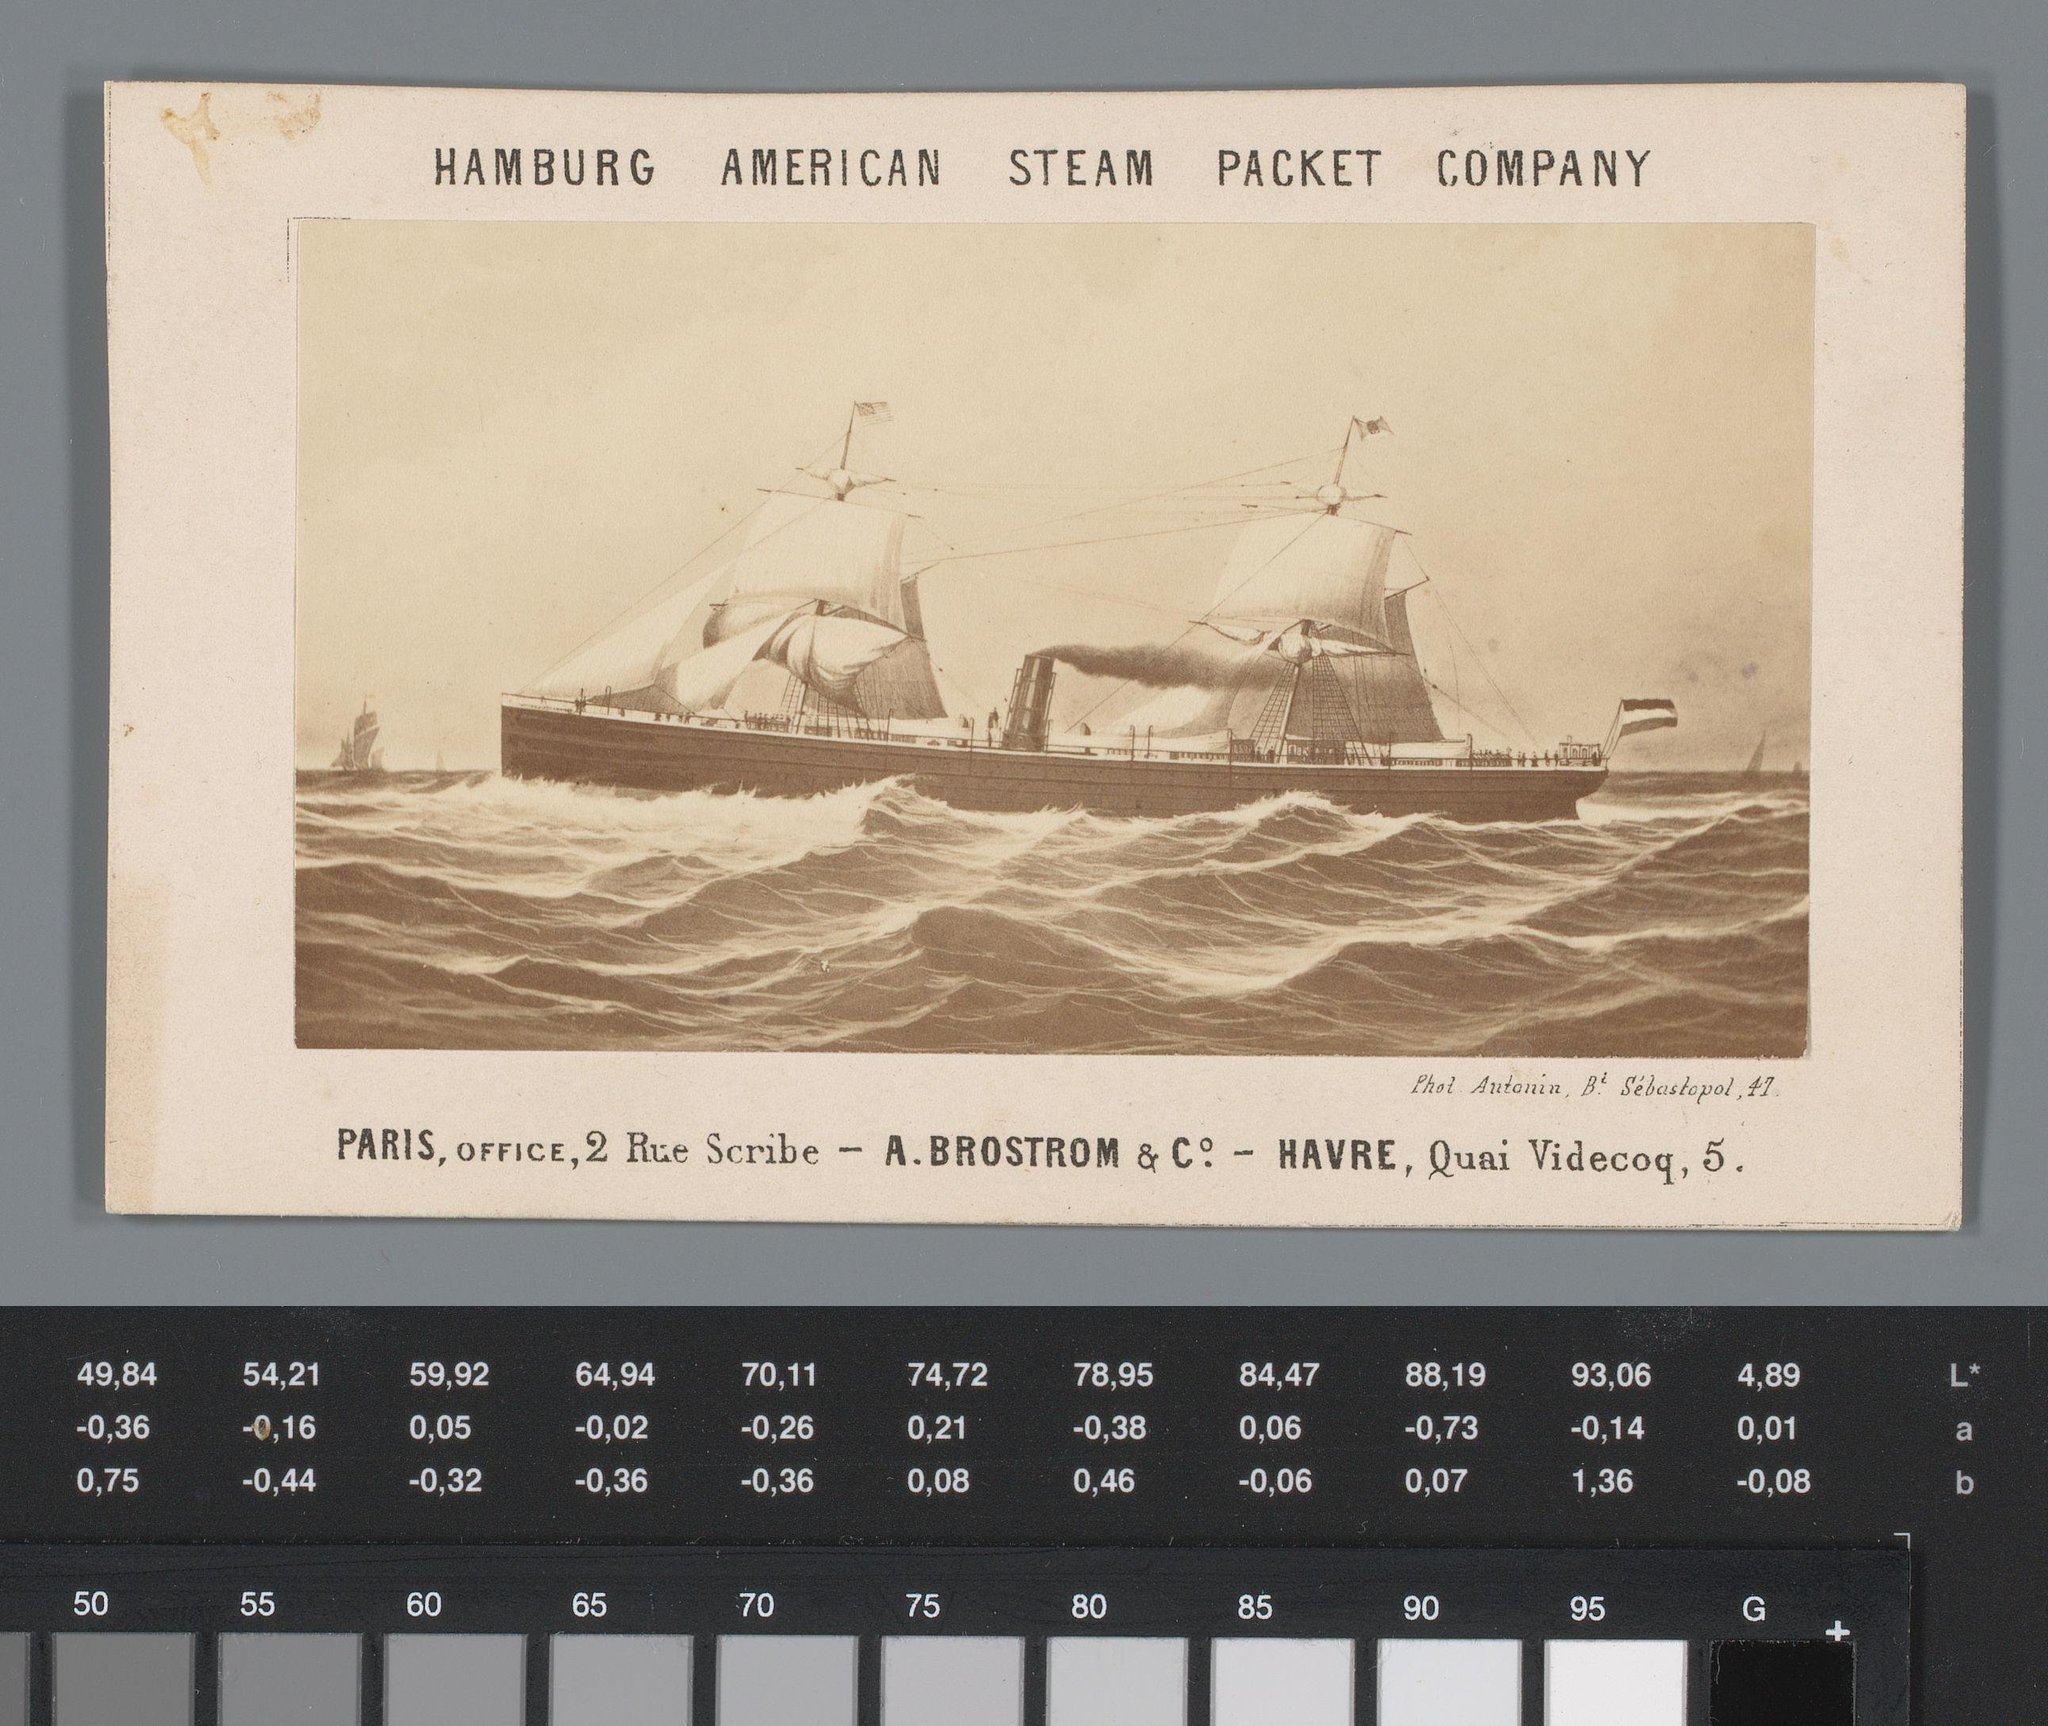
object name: photograph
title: Gezicht op een stoomzeiler van Hamburg American Steam Packet Company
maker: ernest antonin scoquart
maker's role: fotograaf, lithograaf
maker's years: 1825-1898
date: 1860-1880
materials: cardboard, photographic support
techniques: albumen print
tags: steamsailer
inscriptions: inscription: ‘HOLSATIA - WESTPHALIA - SILESIA / (...)’